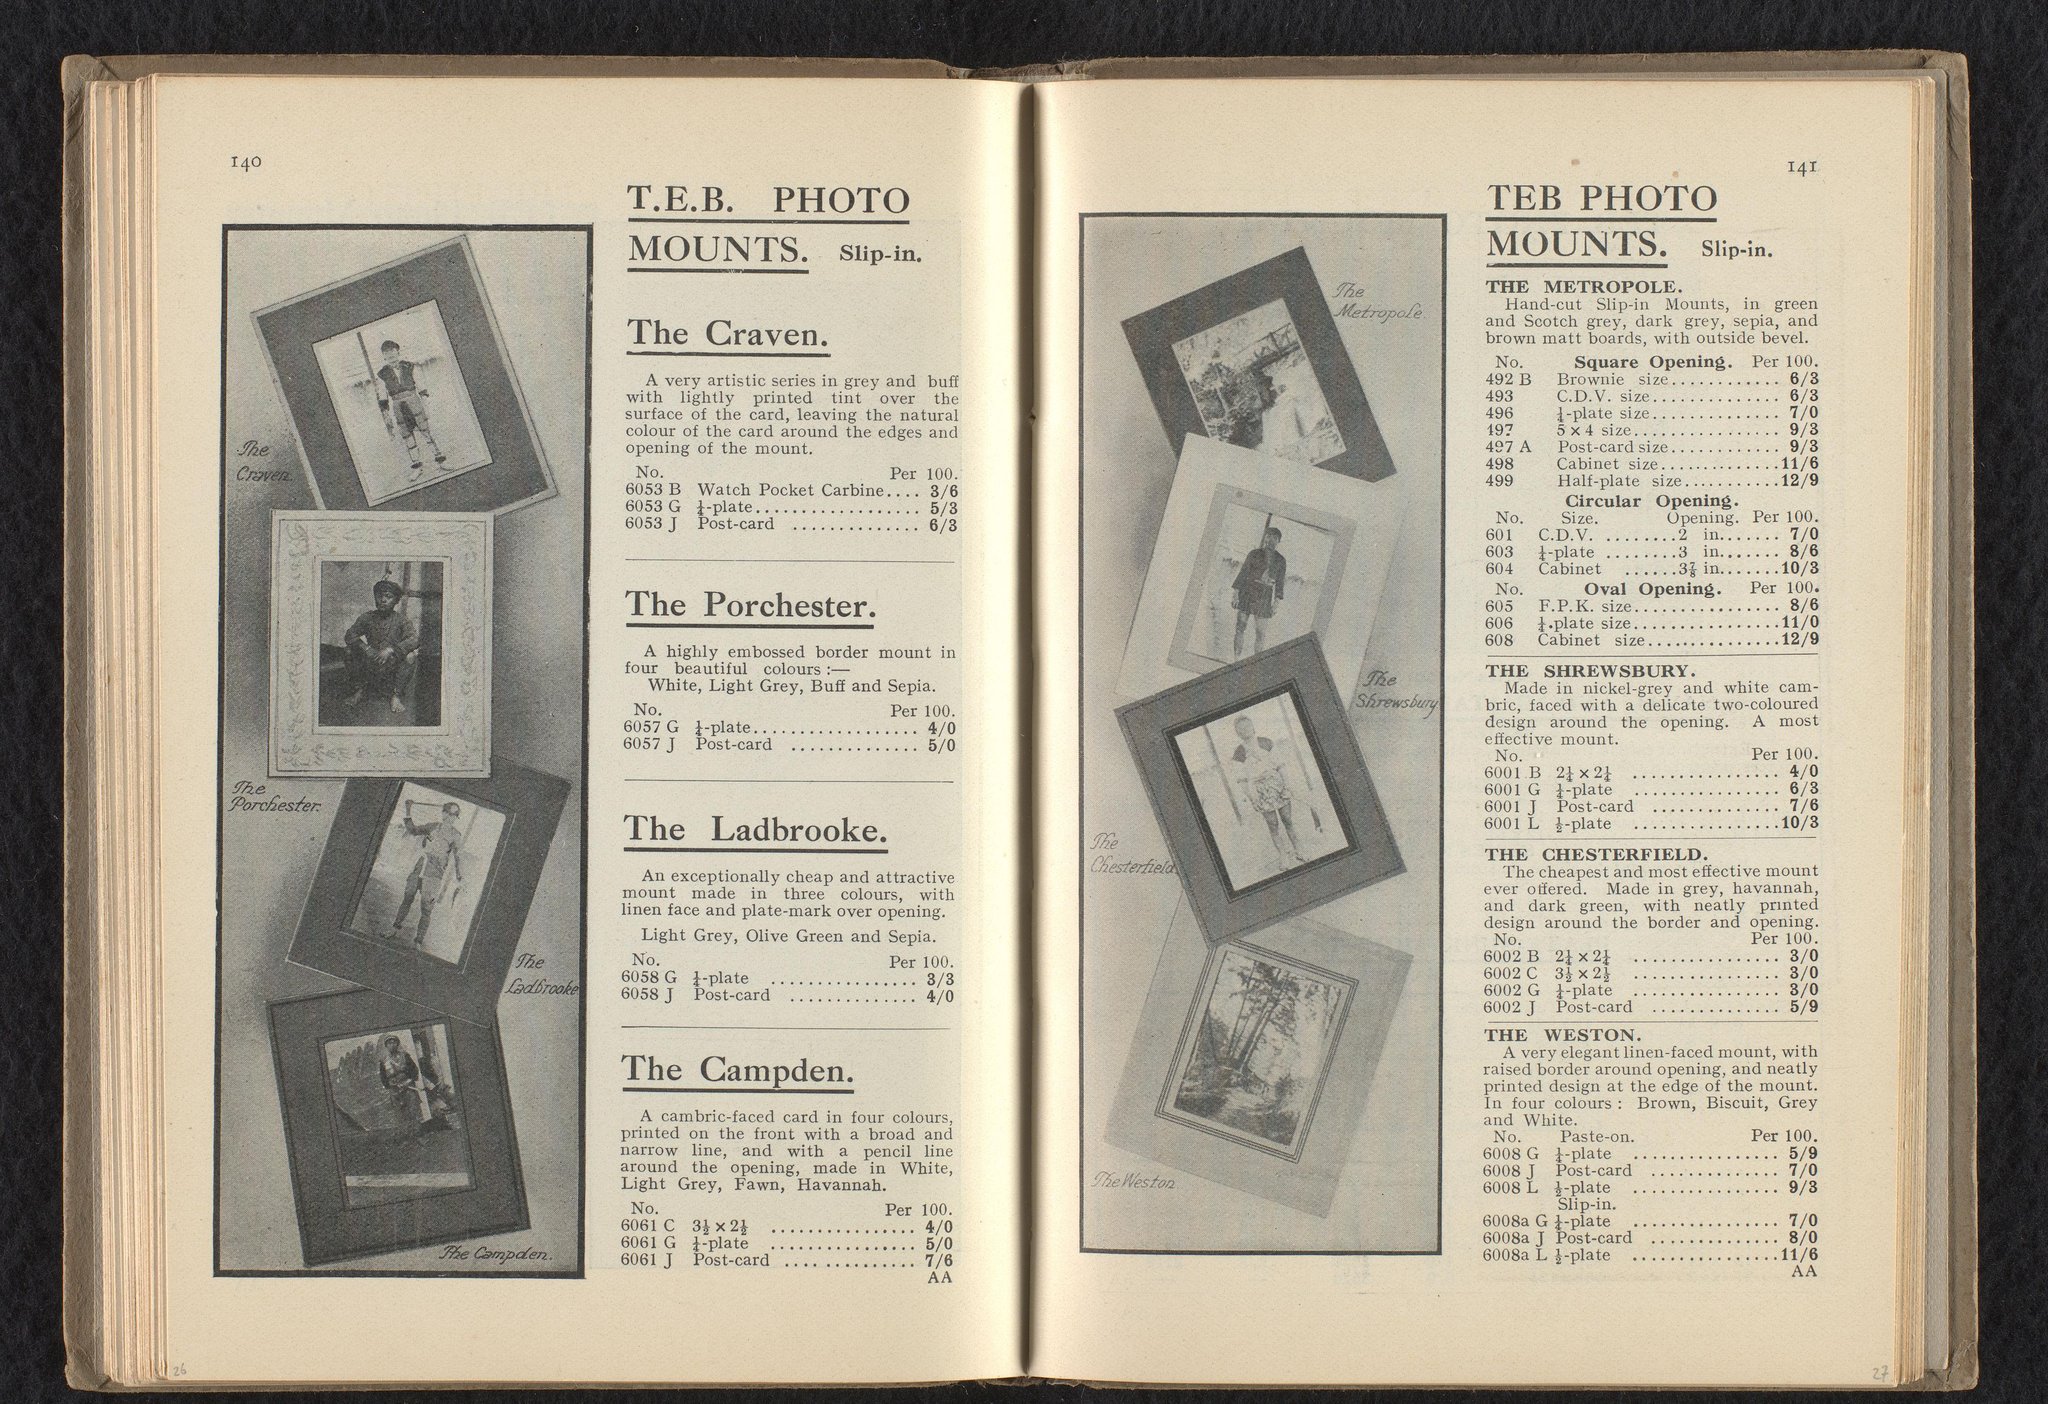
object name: photomechanical print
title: Passe-partouts voor foto's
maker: Anonymous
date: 1907-1912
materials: paper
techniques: letterpress printing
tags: photograph, 'passe-partout'